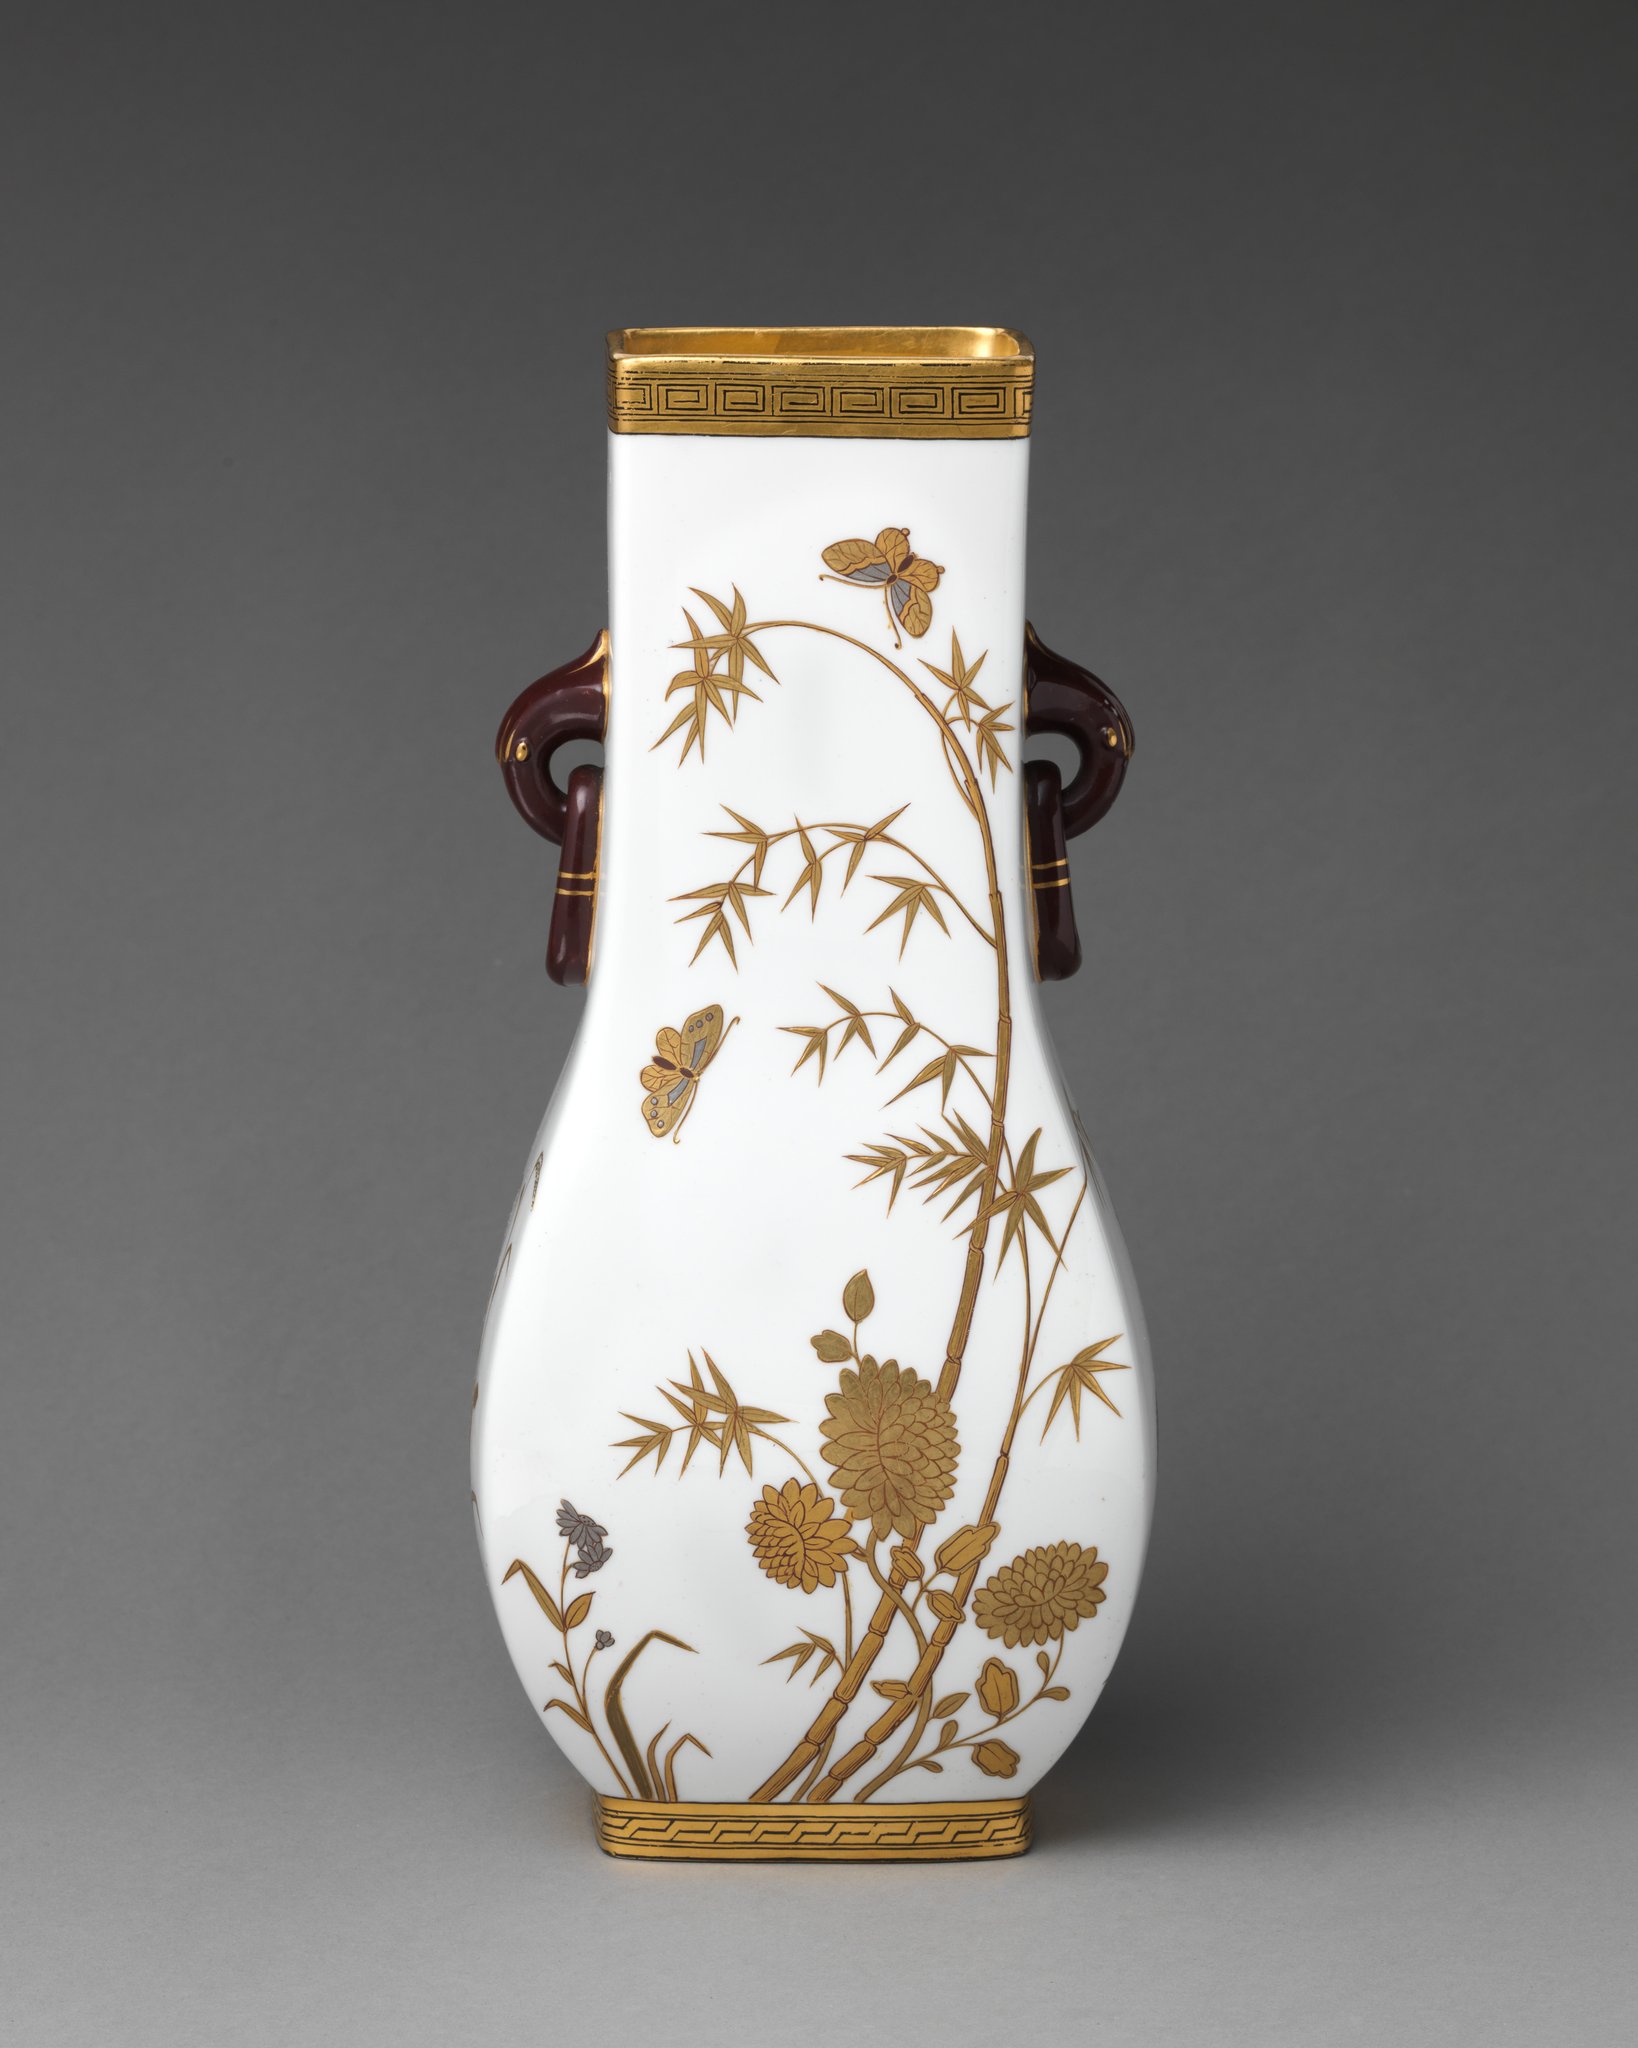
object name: vase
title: Vase with white and gold floral motifs and ring handles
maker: minton(s)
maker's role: maker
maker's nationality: british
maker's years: 1793-2001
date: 1873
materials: bone china